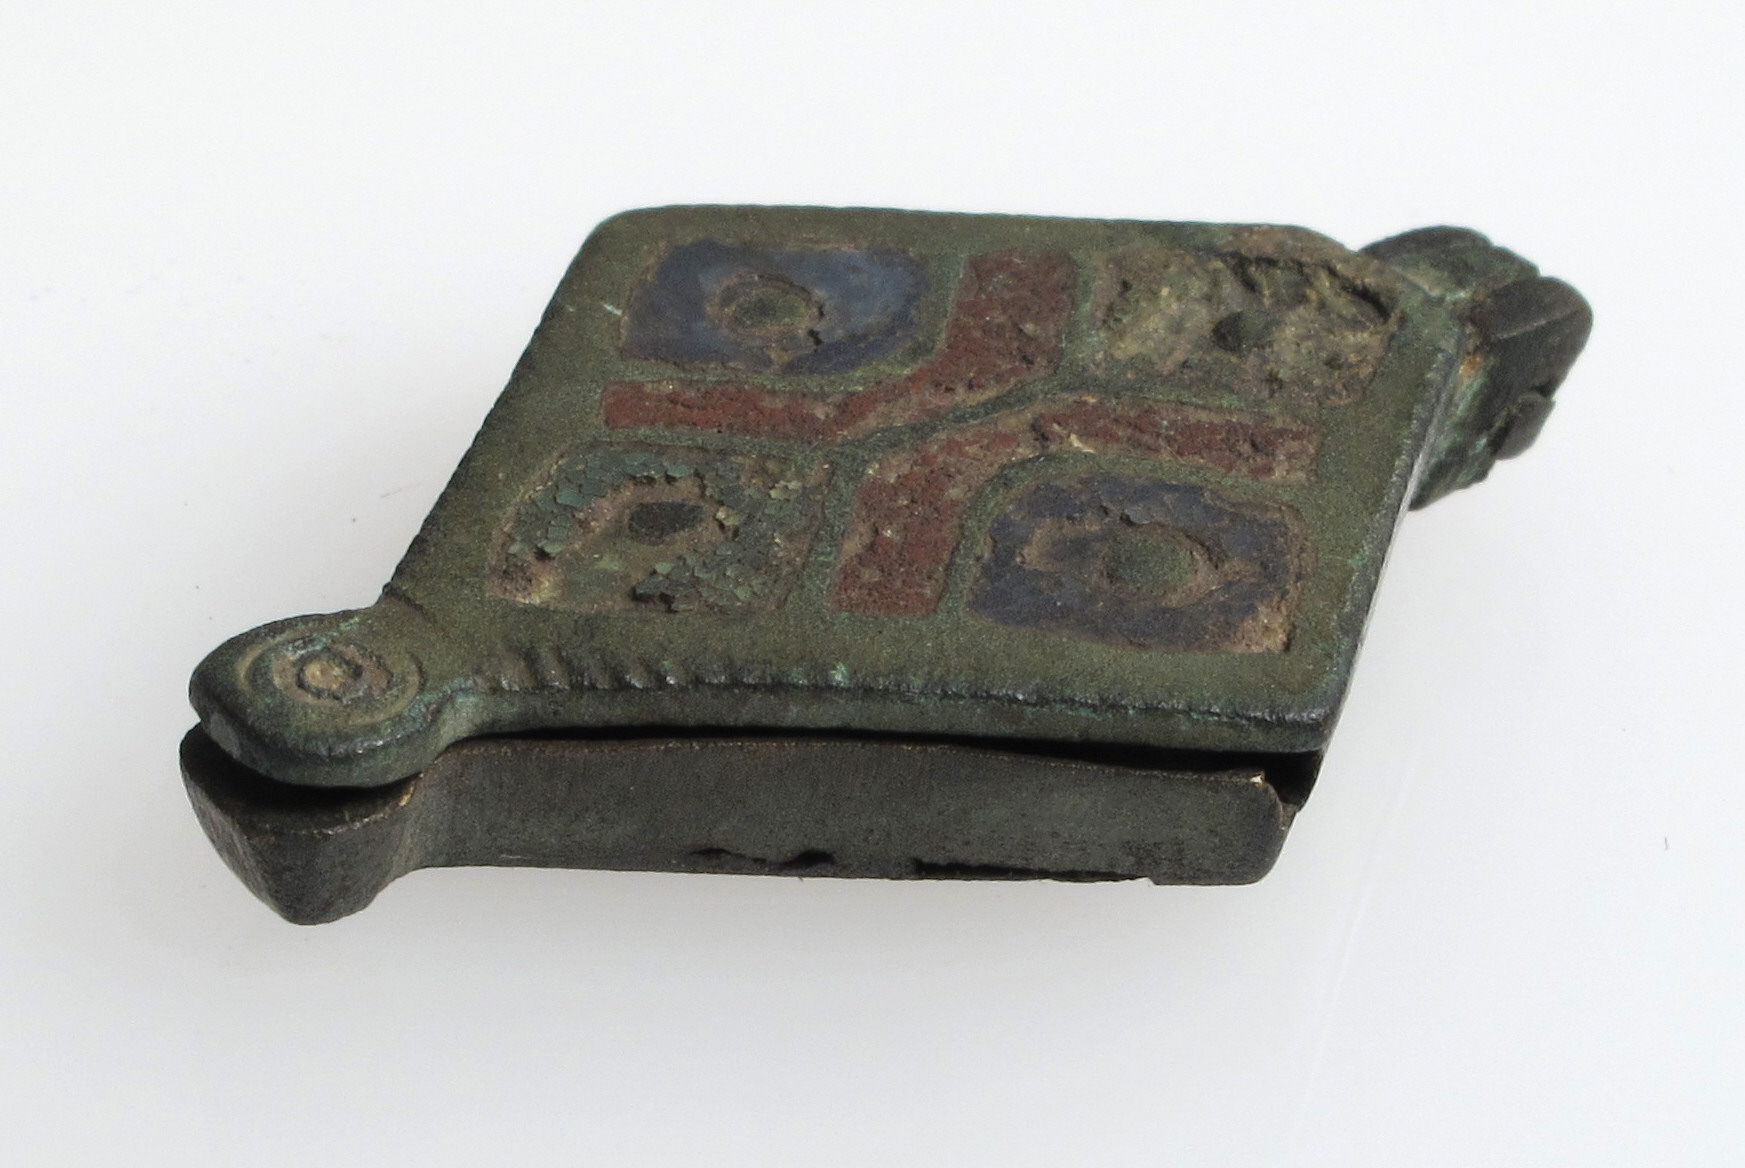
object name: box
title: Seal Box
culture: roman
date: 100-300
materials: bronze, enamel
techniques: enamel